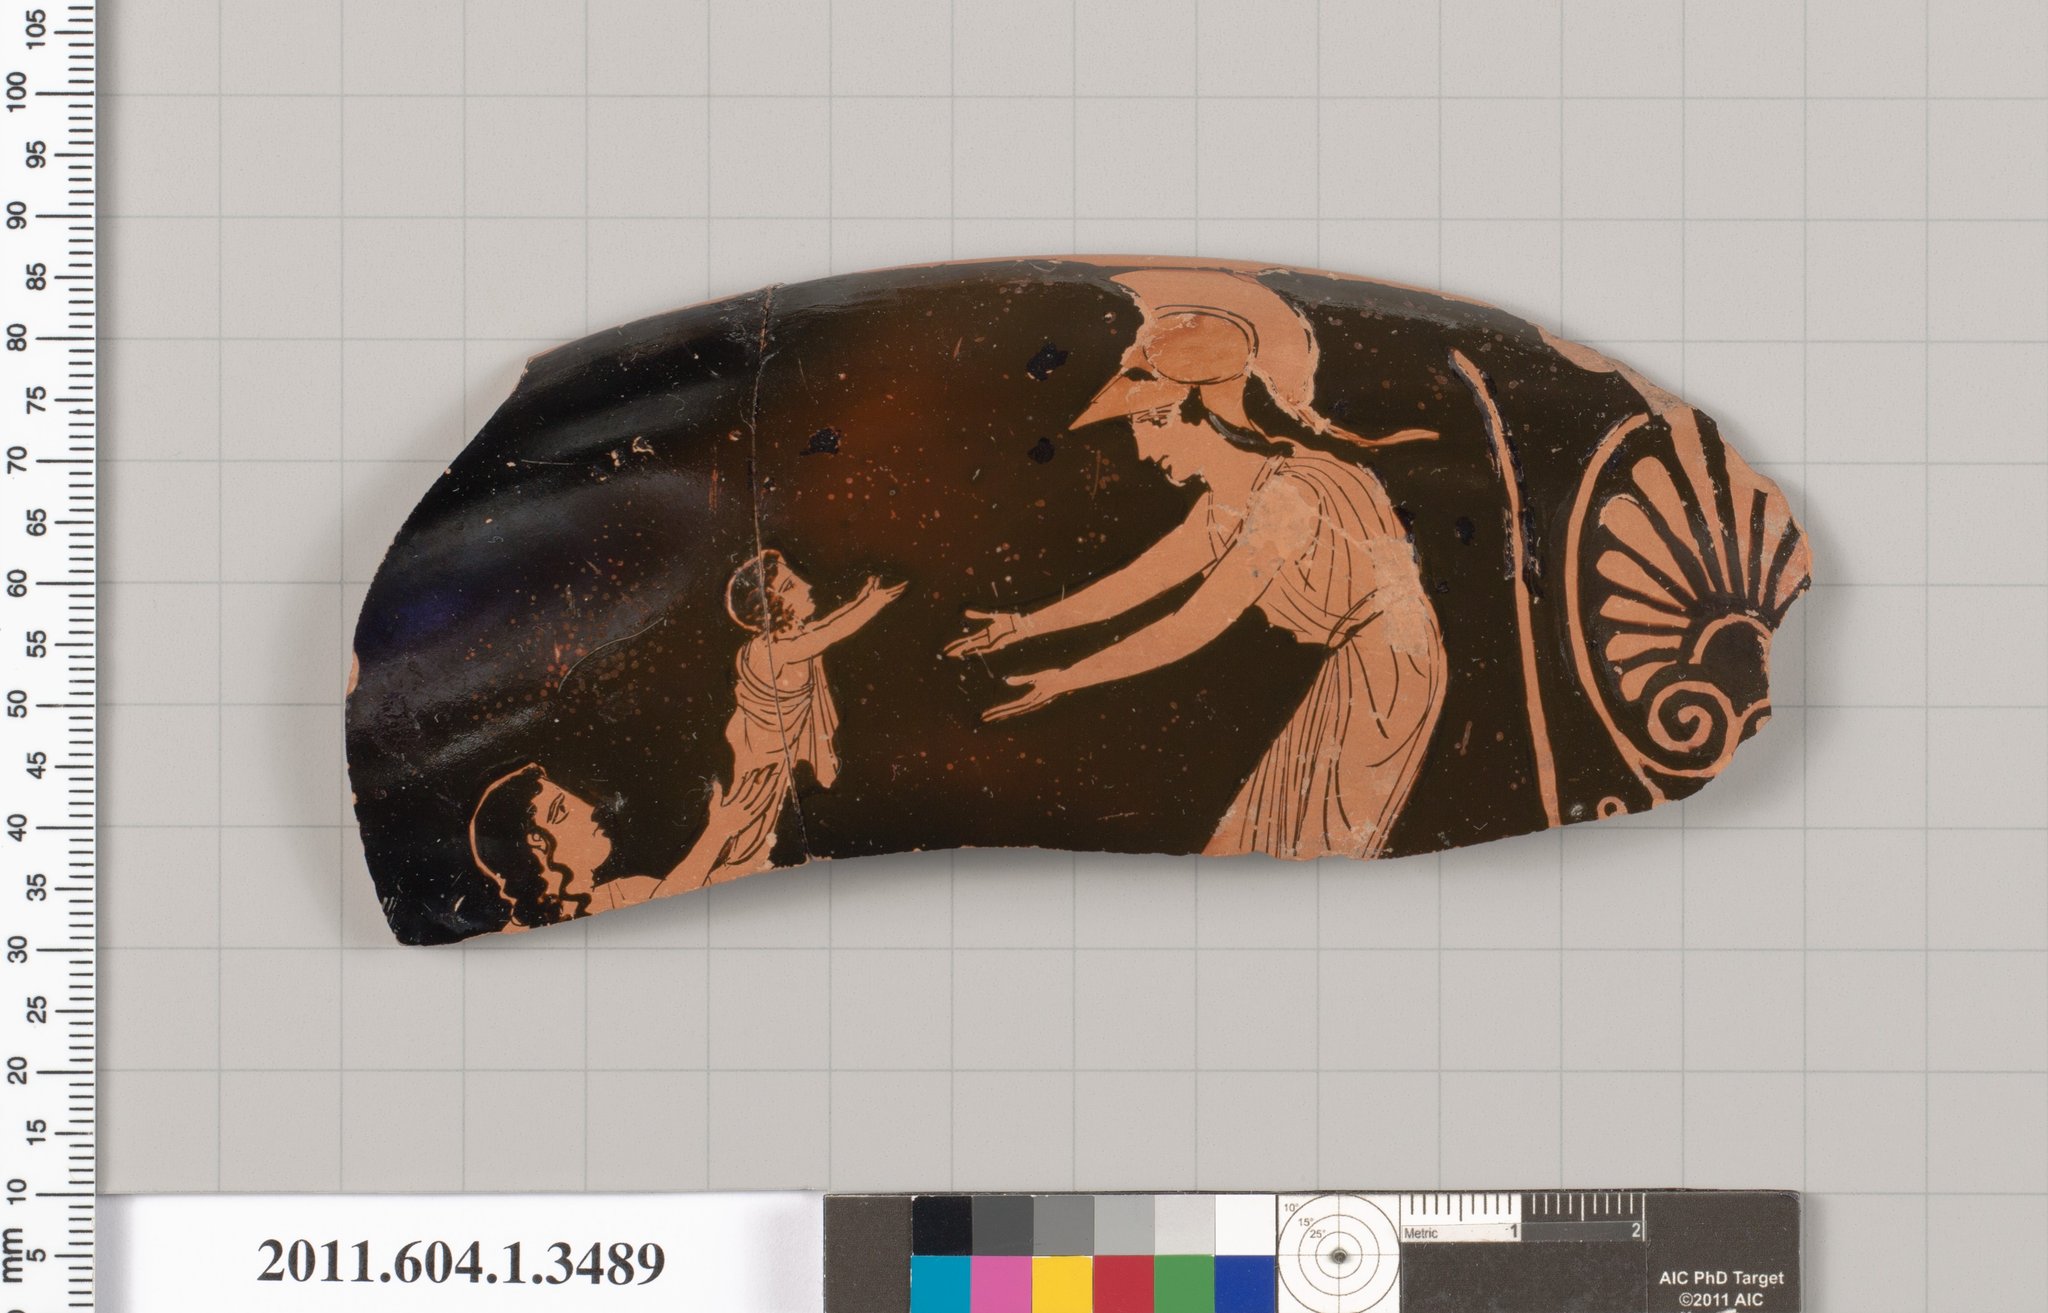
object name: kylix fragment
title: Terracotta fragment of a kylix (drinking cup)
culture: greek, attic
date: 467-435 BCE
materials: terracotta